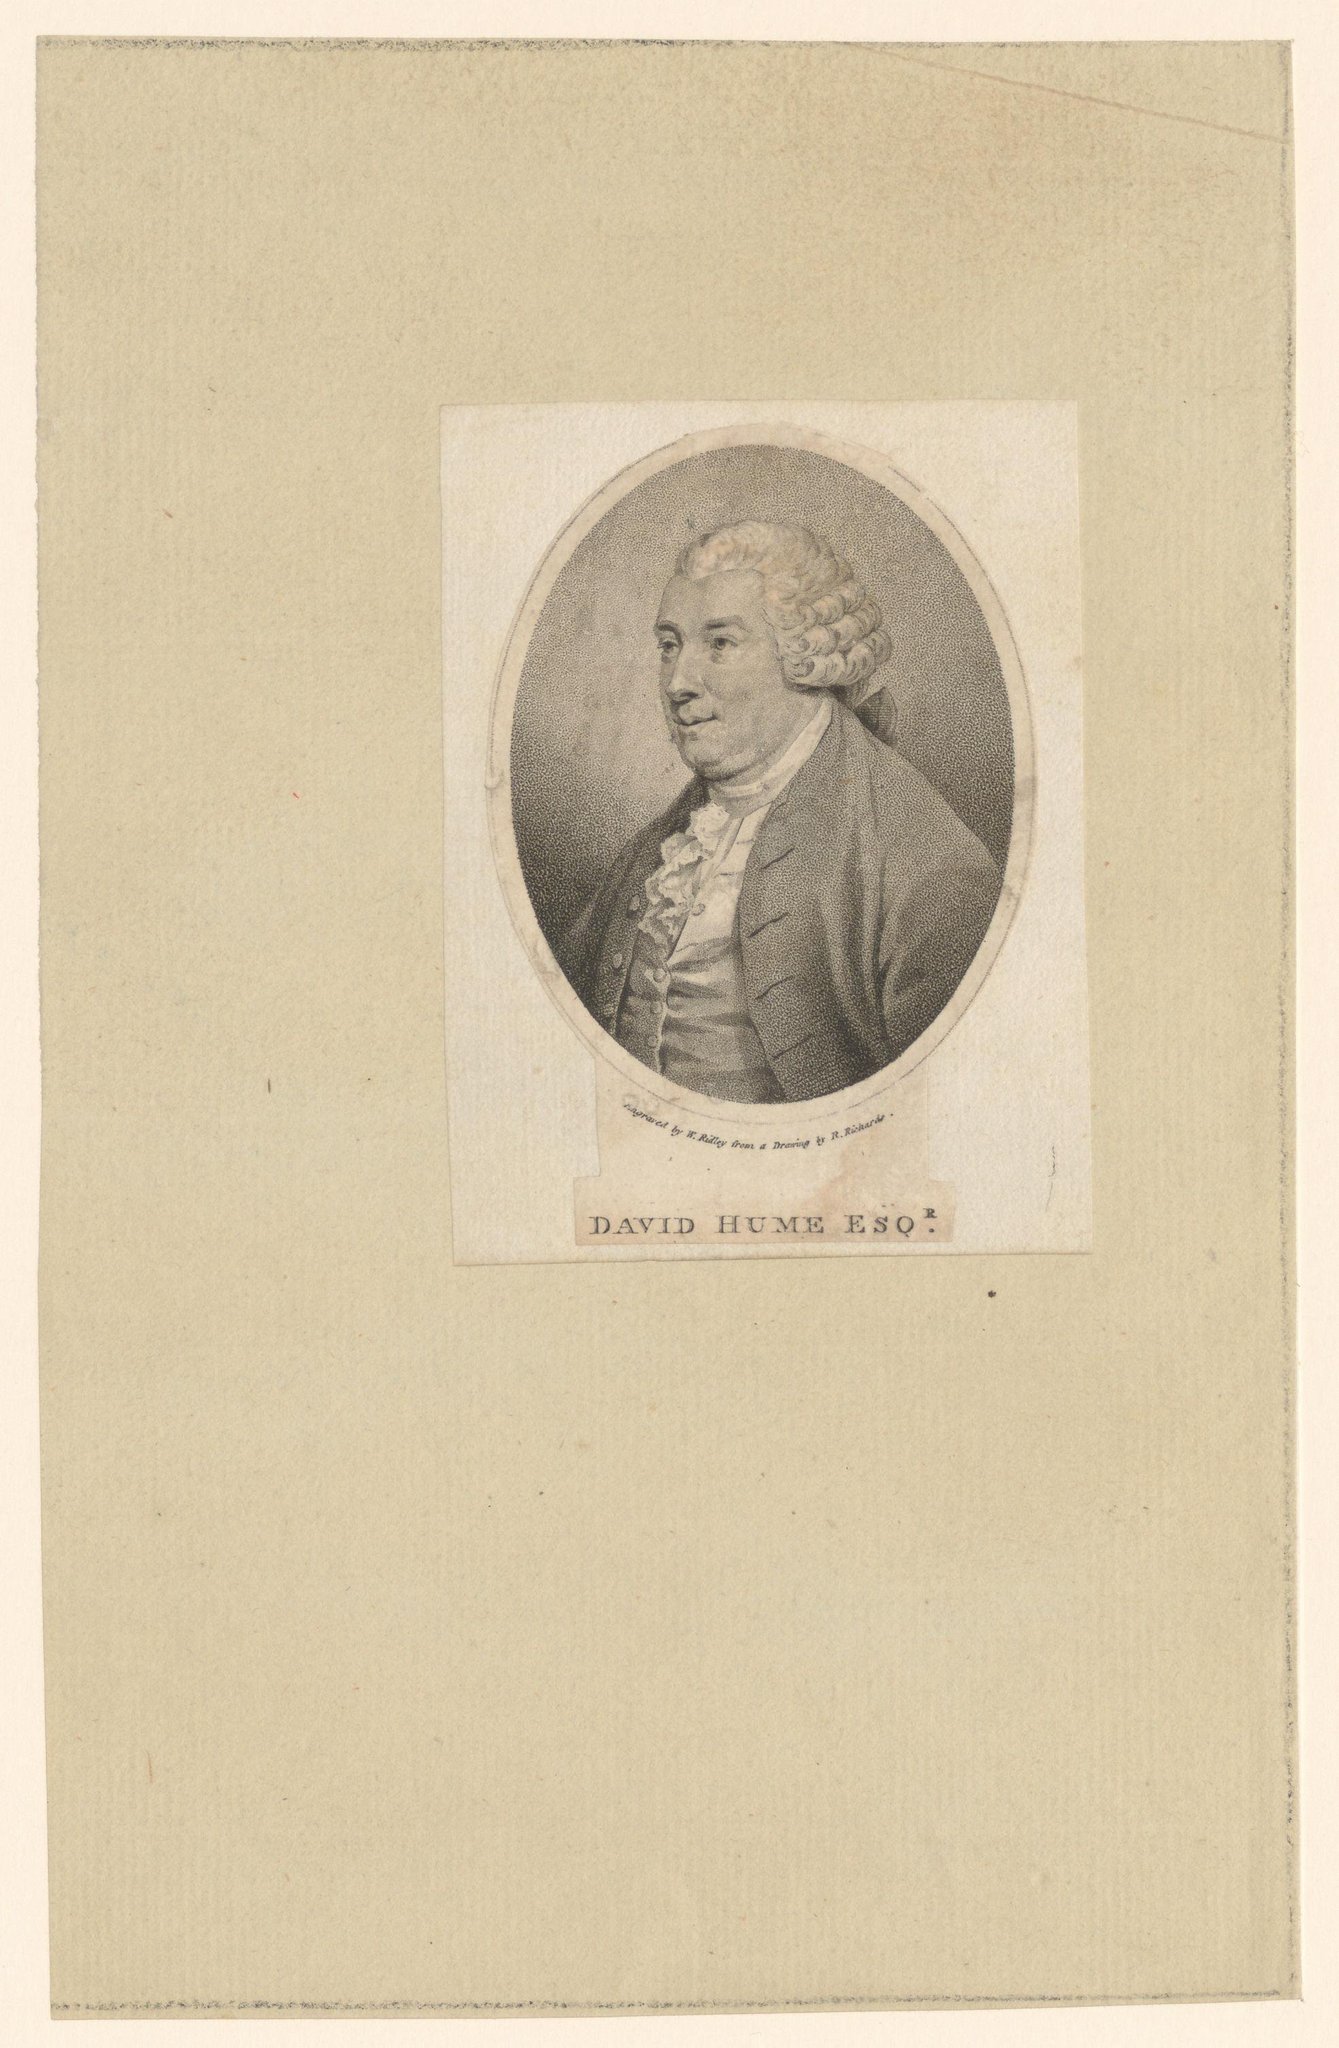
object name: print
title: Portret van David Hume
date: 1774-1838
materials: paper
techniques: stippling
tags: david hume, historical persons, scholar, philosopher (+ portrait of scholar, scientist)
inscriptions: collector's mark: Lugt 2228